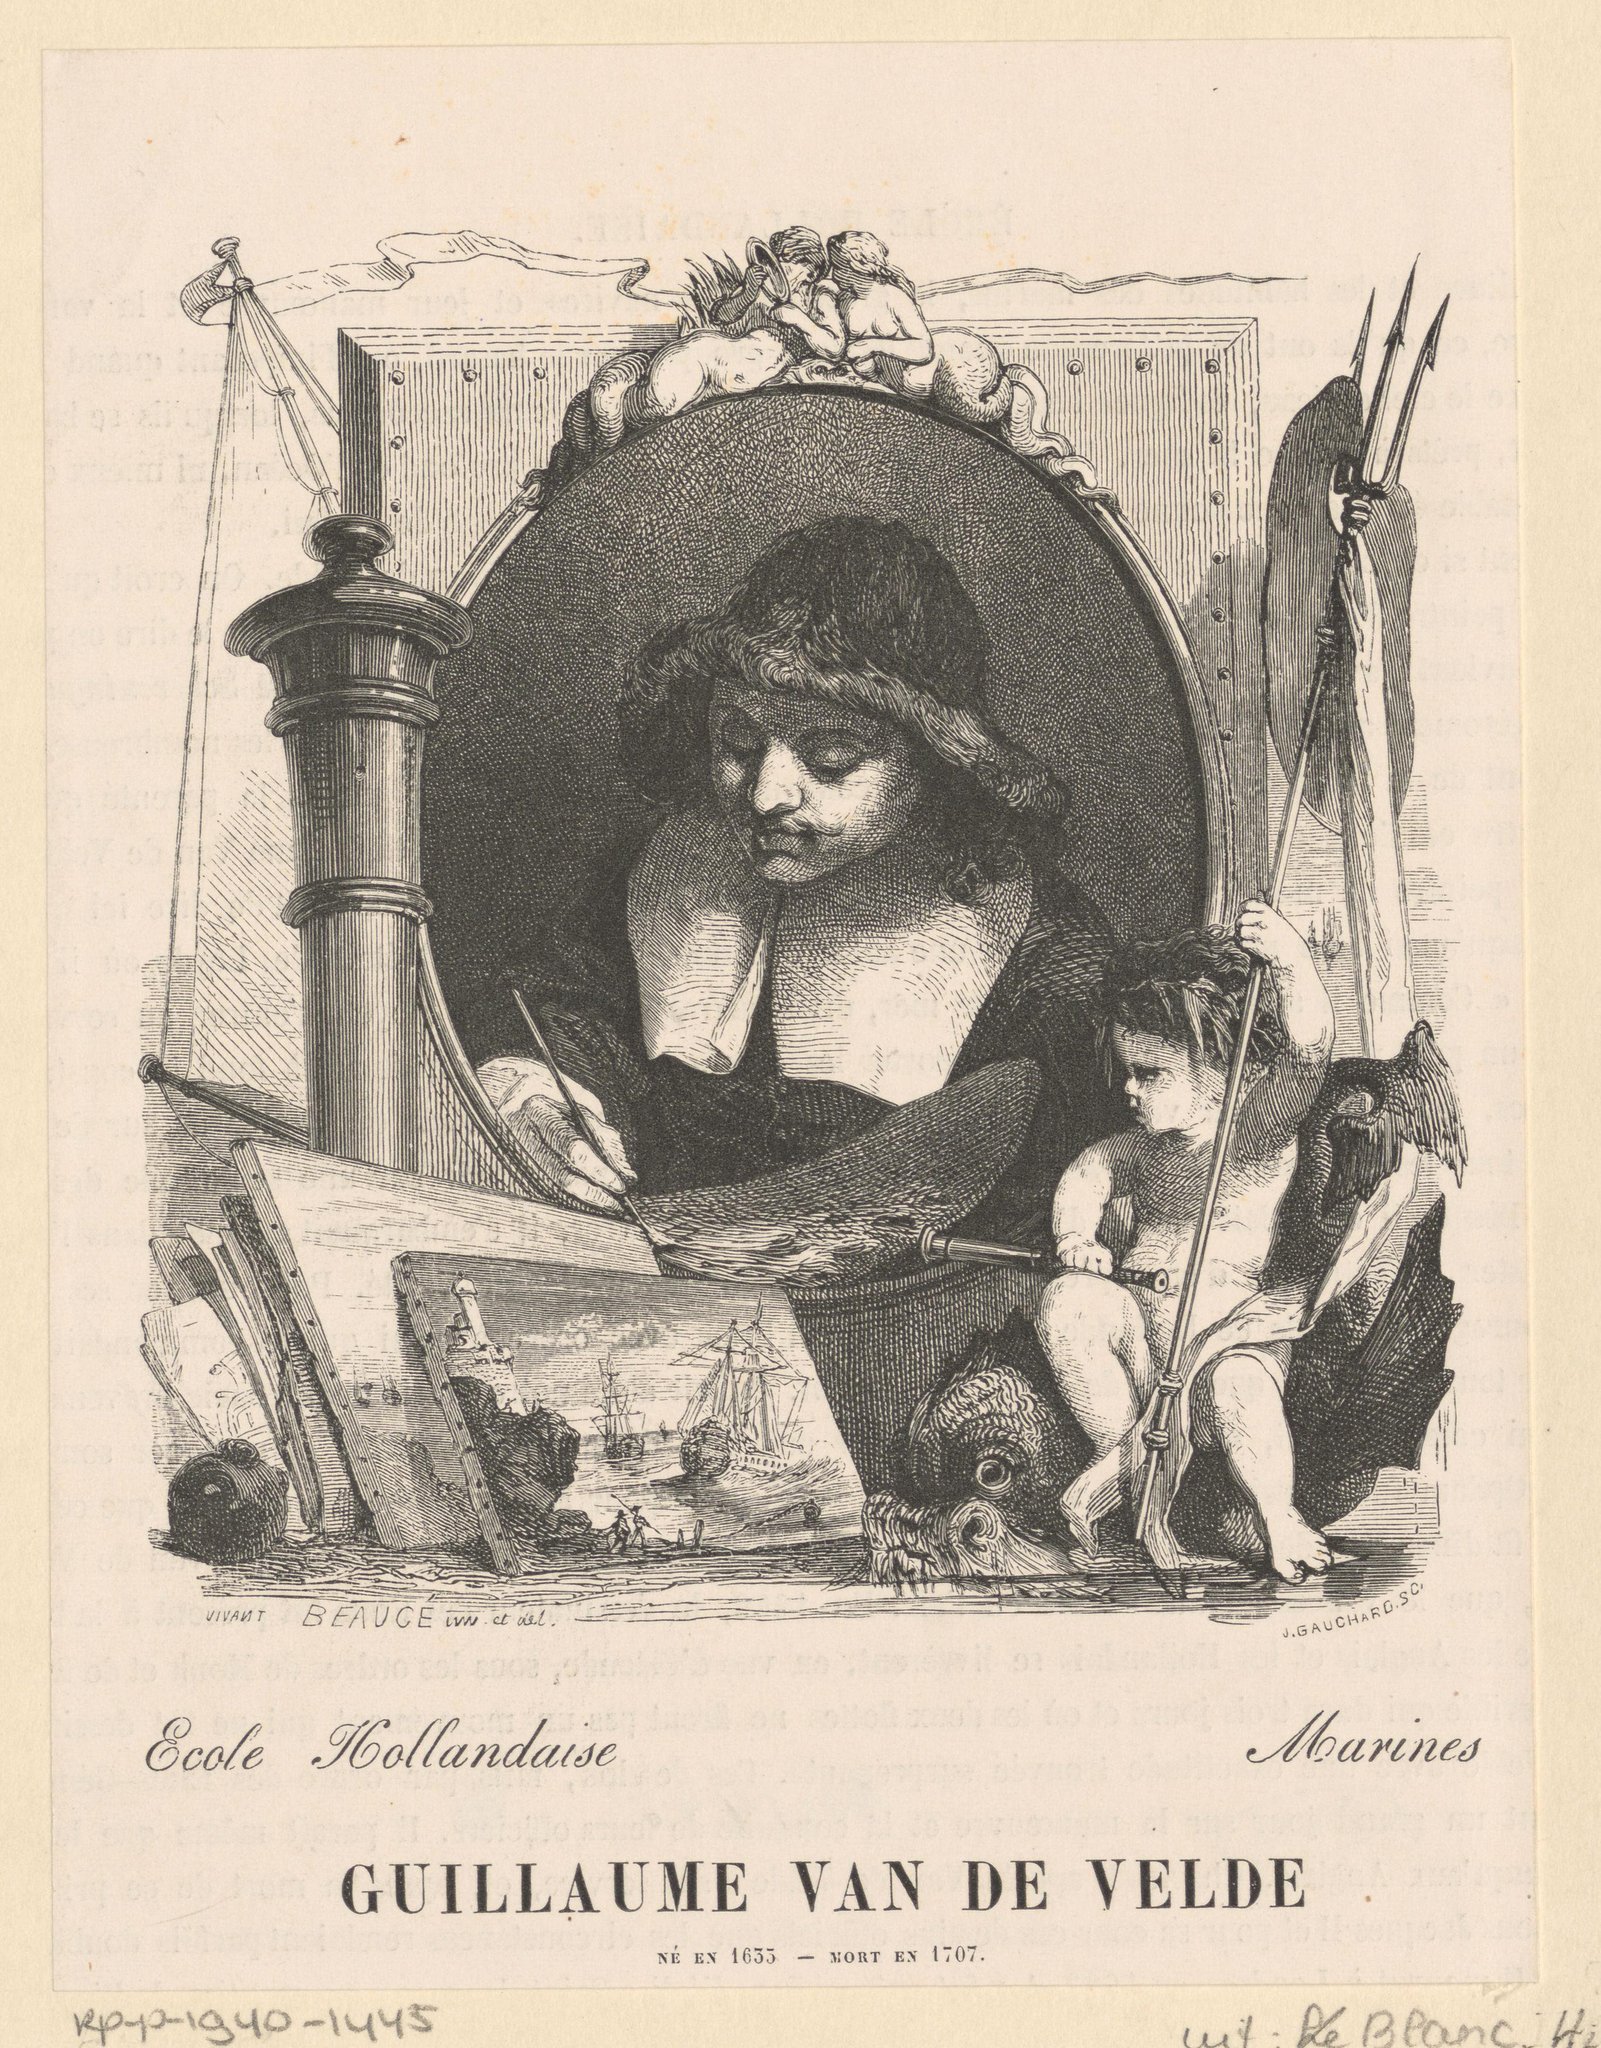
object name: print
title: Portret van Willem van de Velde II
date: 1861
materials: paper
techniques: letterpress printing, engraving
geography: paris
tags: leiden, london, painter, draughtsman, willem van de velde (ii), sail, historical persons, portrait, self-portrait of painter, tools, implements of painter, palette, picture, painting, attributes of neptune: trident, binoculars, spy-glass, etc.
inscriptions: collector's mark: Lugt 2228, collector's mark: Lugt 2760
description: Prent uit: Blanc, Charles. Histoire des peintres de toutes les écoles (...). Parijs: veuve Jules Renouard, 1861.